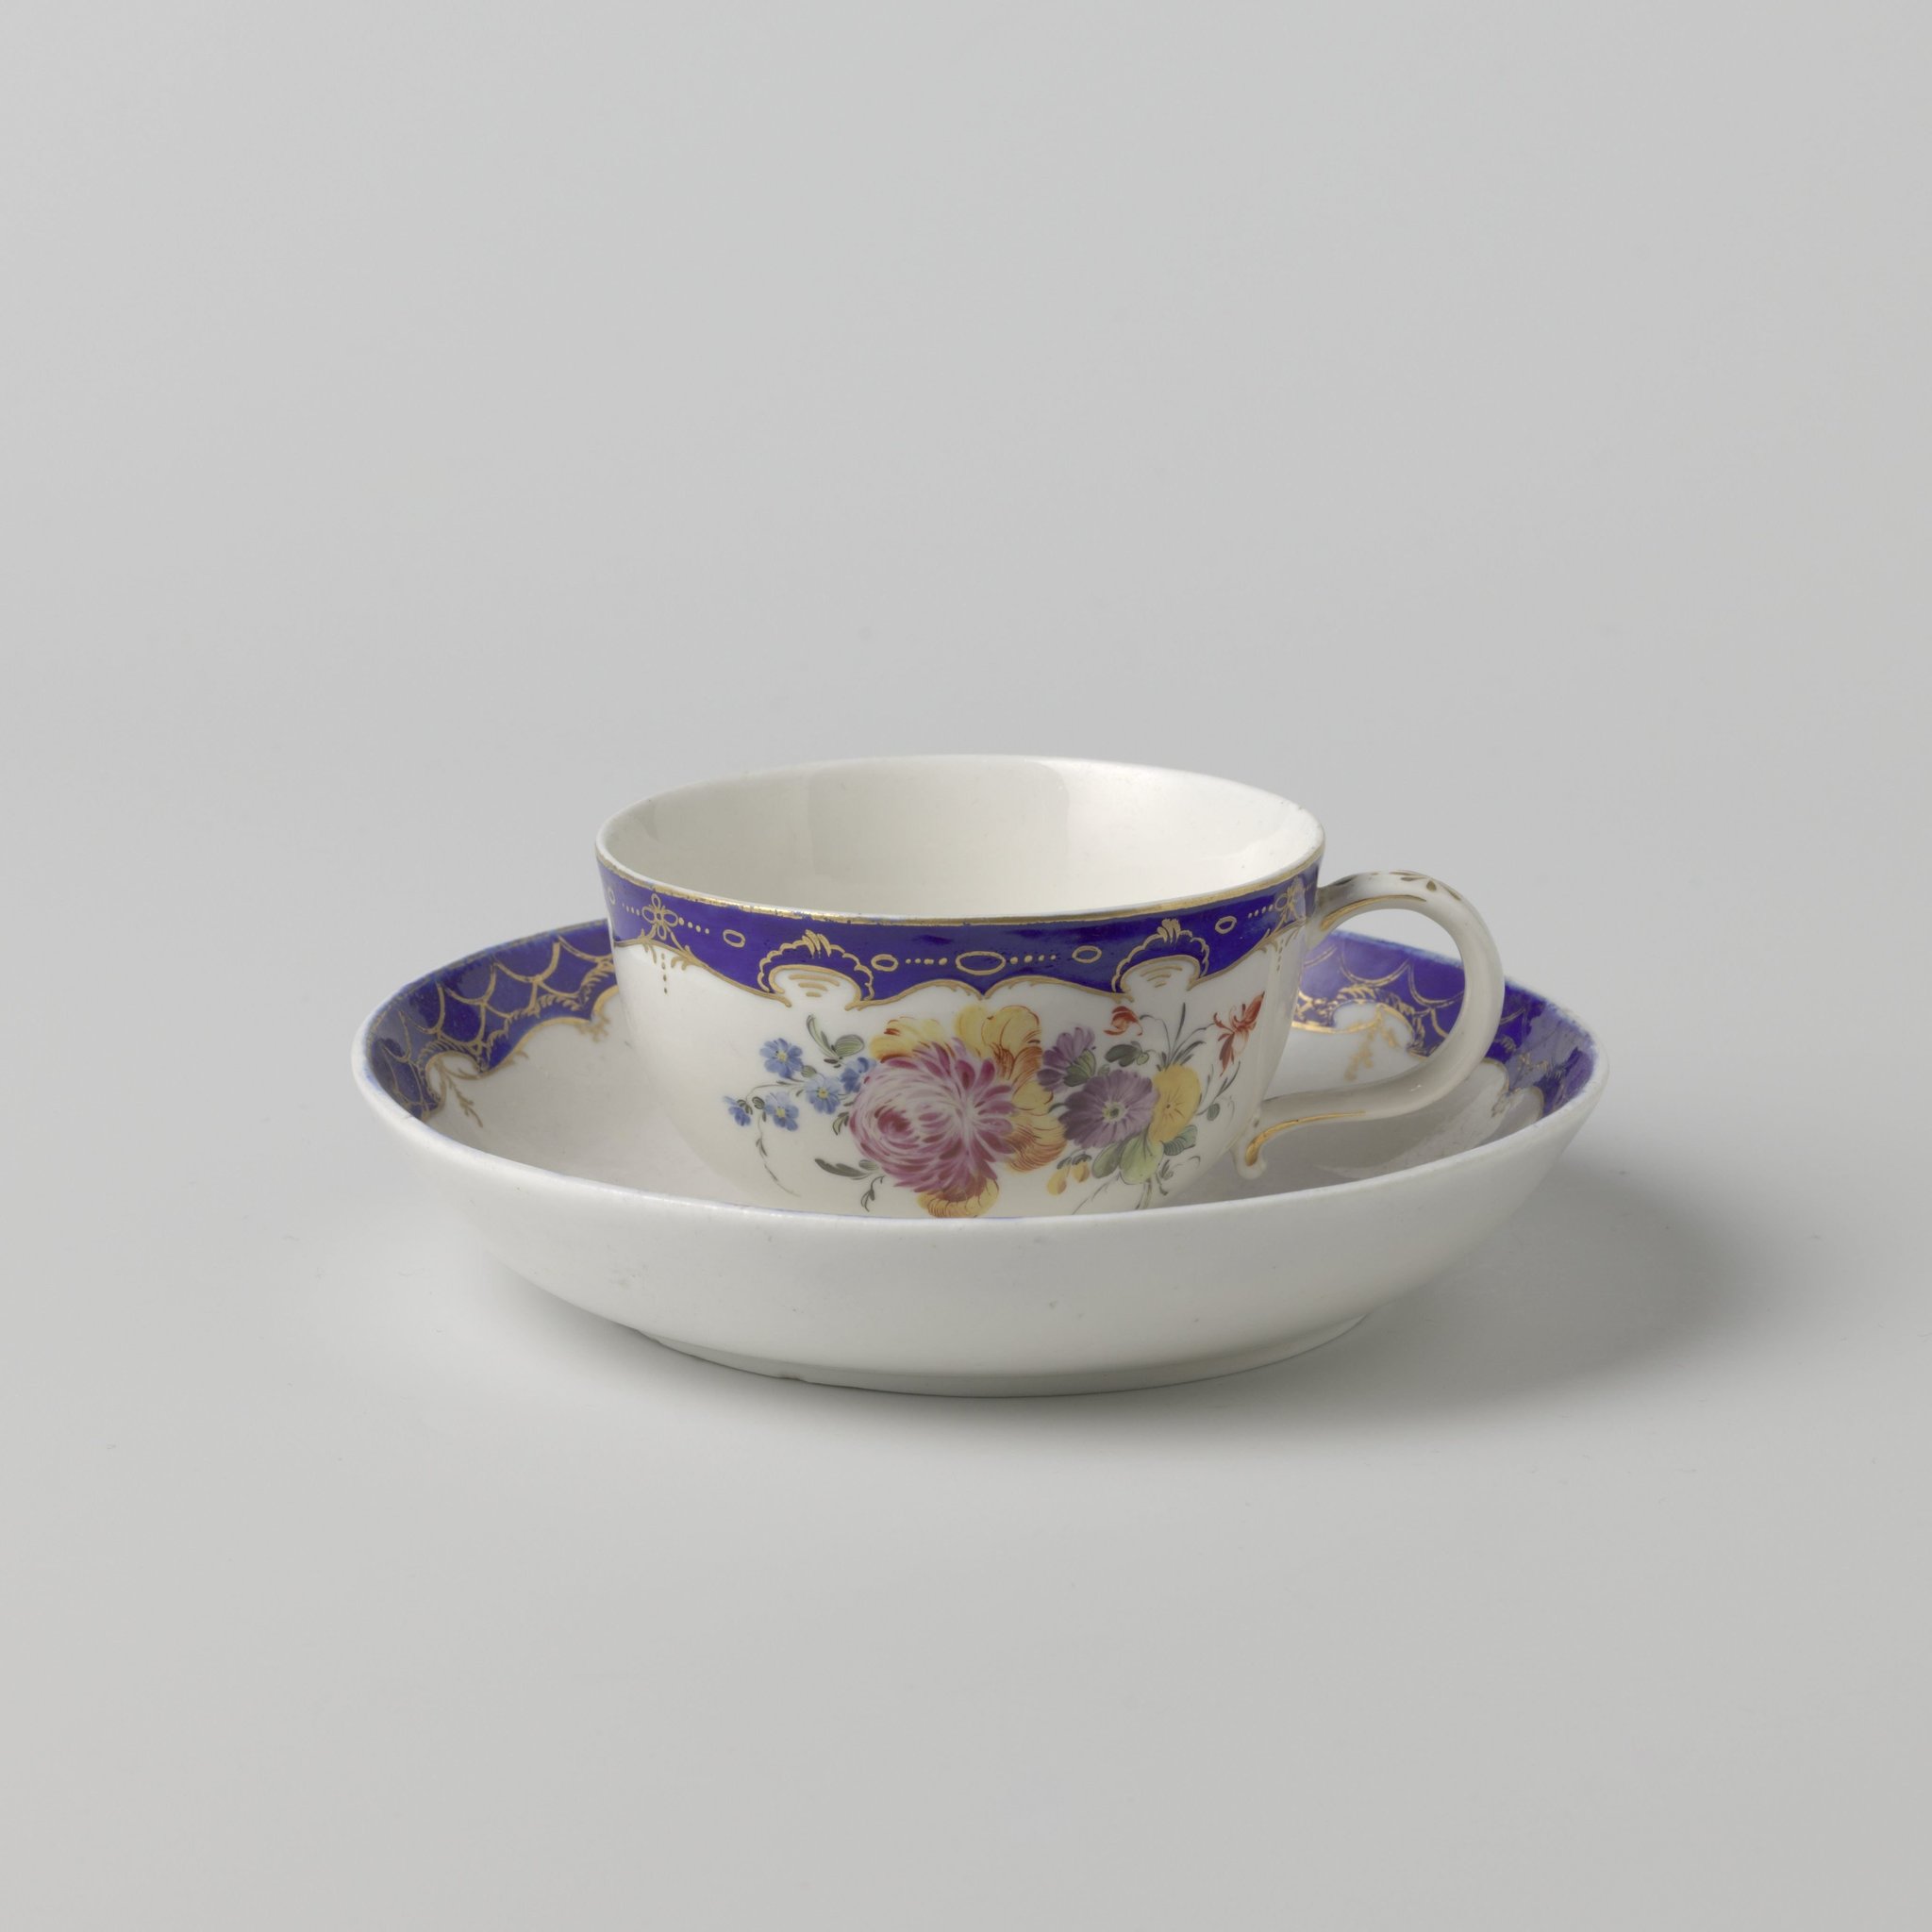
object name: platter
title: Schotel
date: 1777-1790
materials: porcelain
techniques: painted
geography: the hague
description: Schotel, onderdeel van theeservies. Op de rand een blauwe band met rocaille ornament. Het hoofdmotief bestaat uit een bloemboeket omgeven door strooibloemen. Gemerkt met een ooievaar in bovenglazuurblauw. N.B. Doorniks zacht porselein beschilderd te Den Haag.